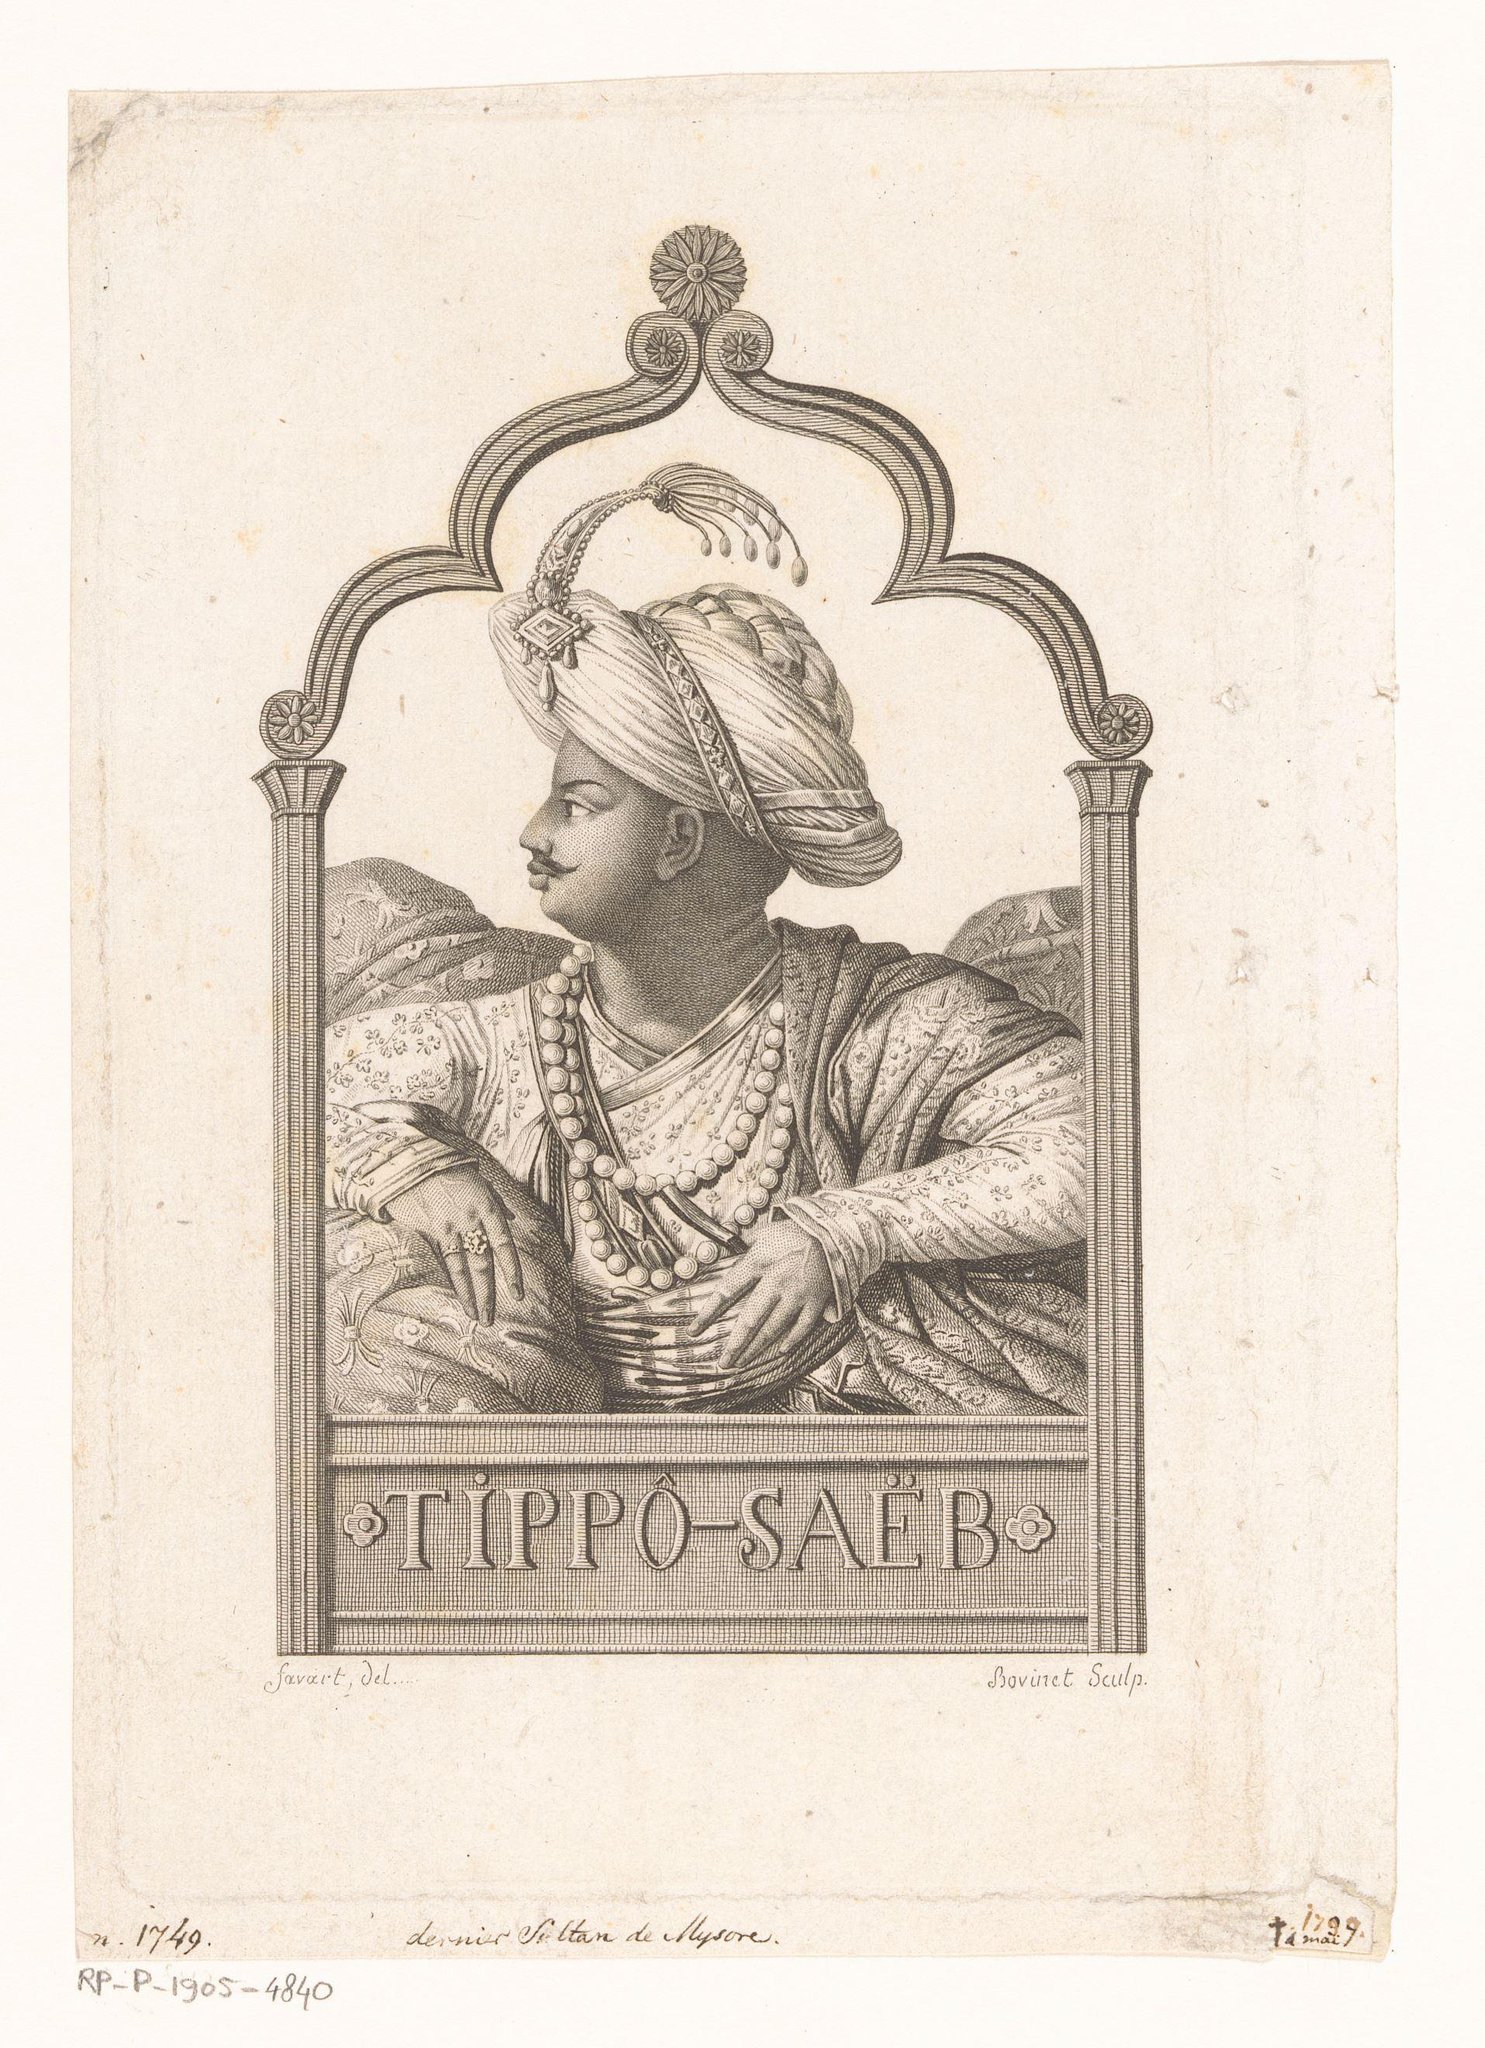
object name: print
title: Portret van Tipu Sahib, Sultan van Mysore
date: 1777-1832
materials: paper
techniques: etching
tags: other sovereign, historical persons, ornaments, jewels, head-gear: turban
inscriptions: collector's mark: Lugt 2228